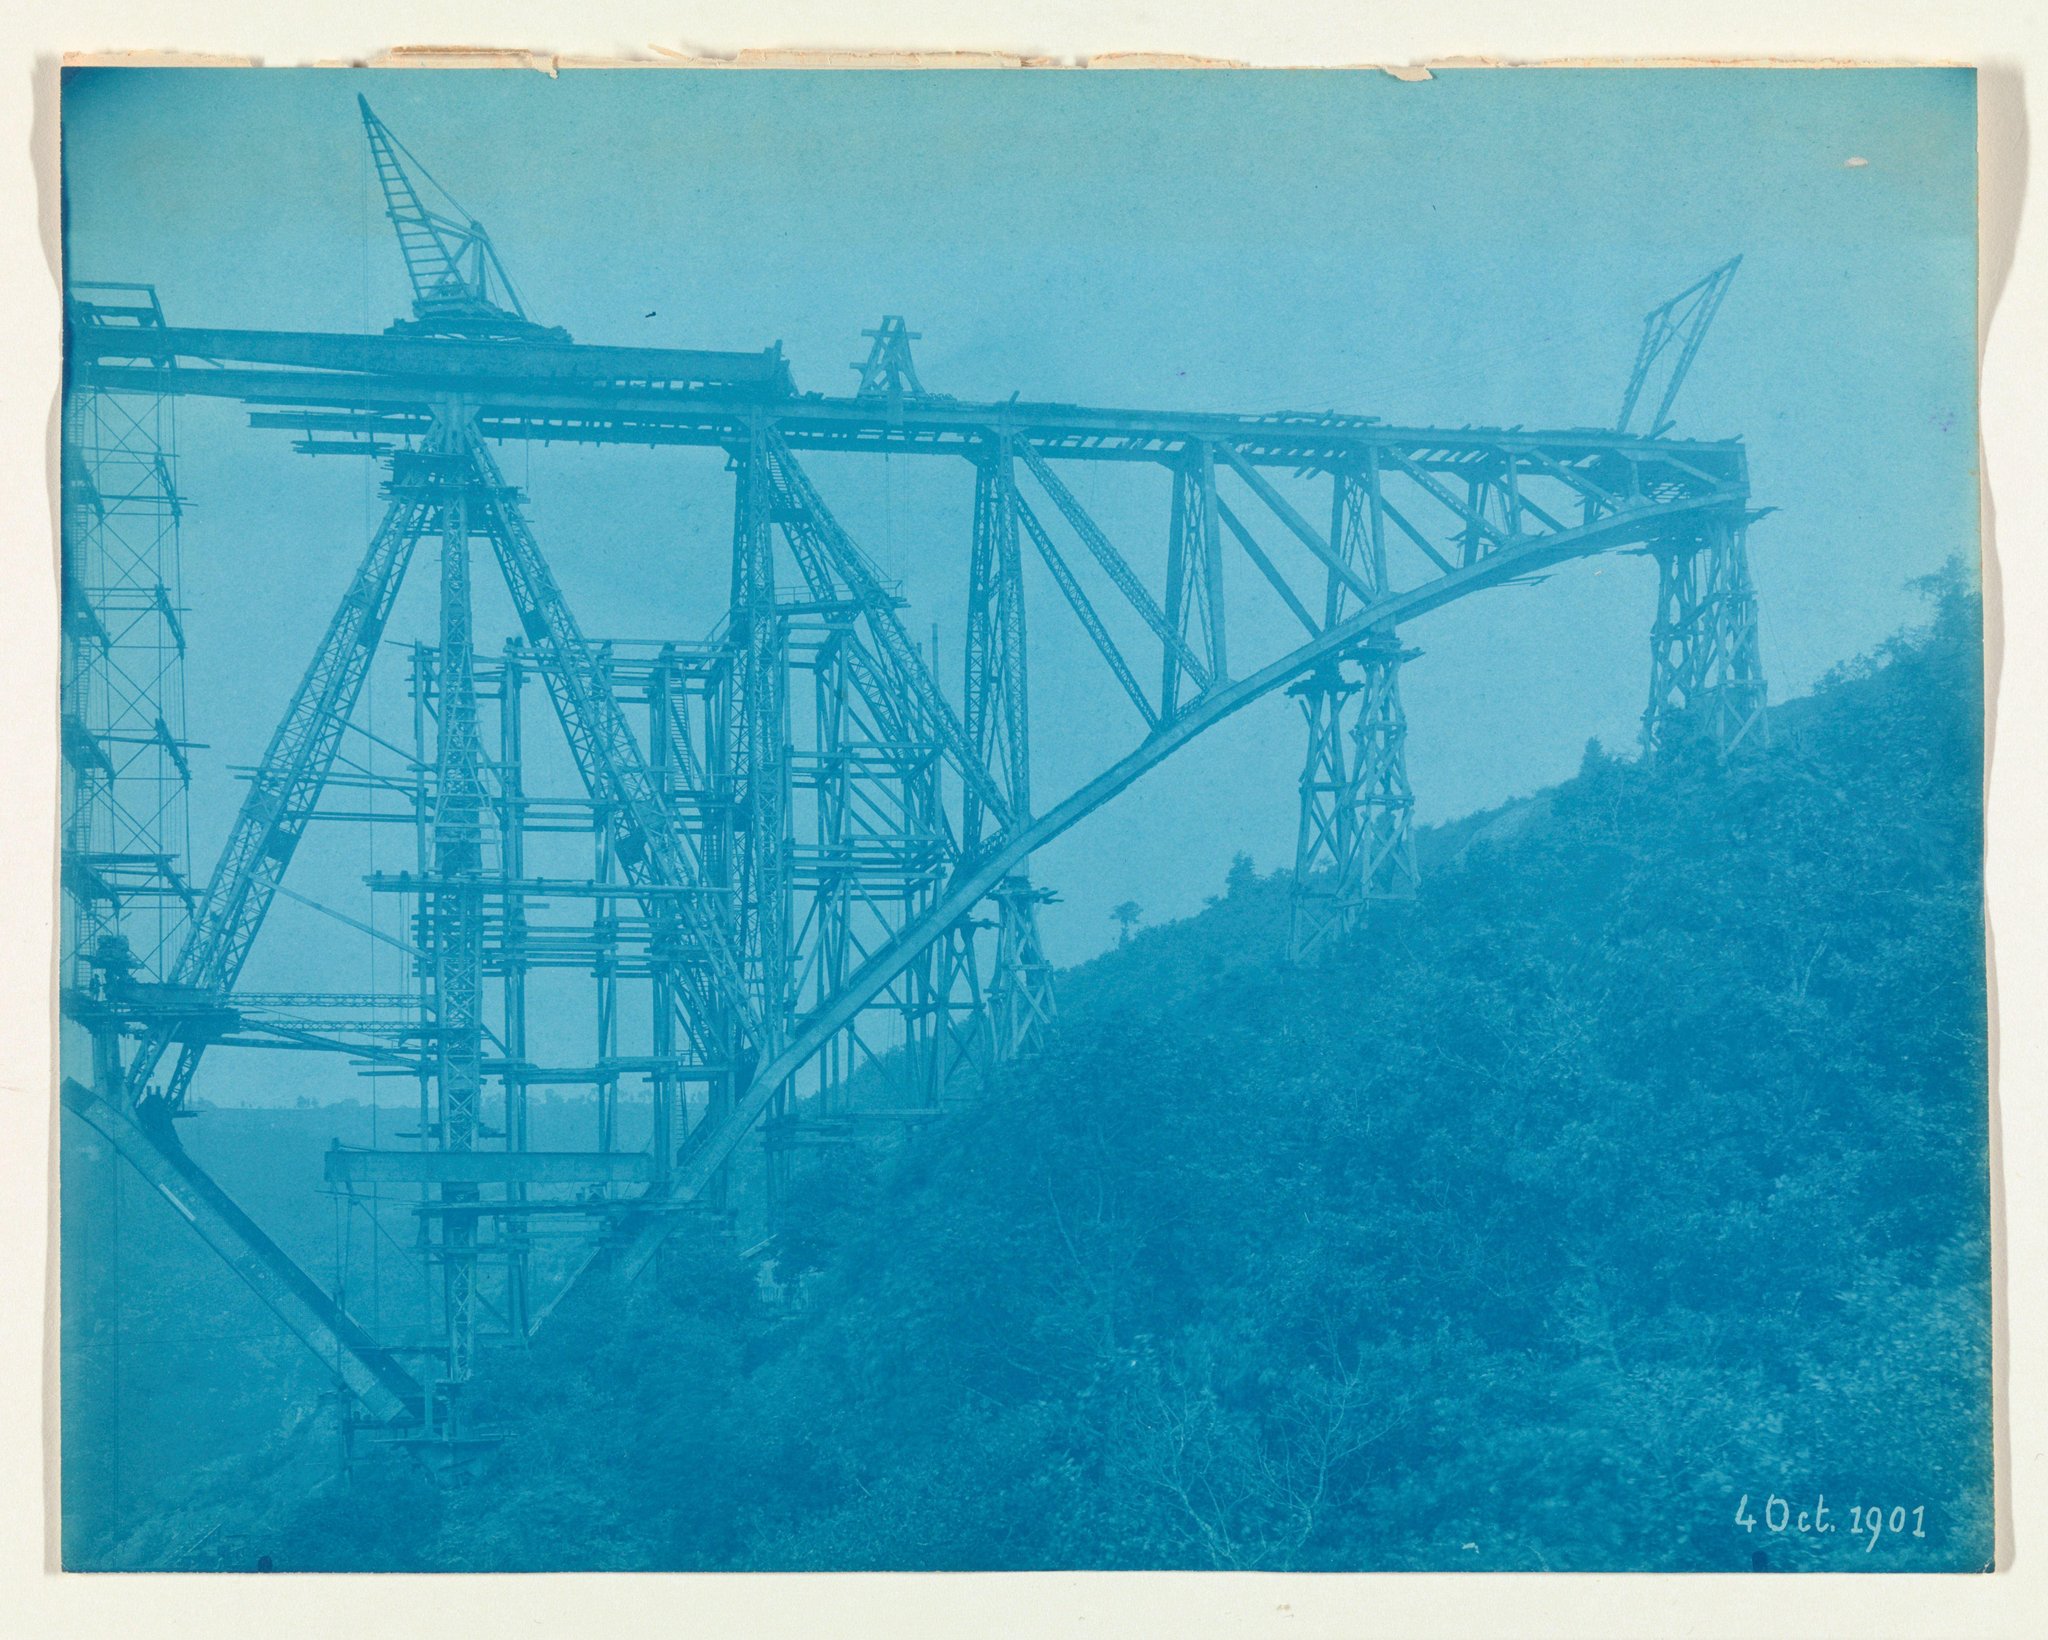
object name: photograph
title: Aanleg van het Viaur Viaduct in Frankrijk door de Societé de Construction des Battignolles, 4 oktober 1901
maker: Anonymous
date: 1901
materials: photographic support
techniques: cyanotype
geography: france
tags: viaduct, making the overground structures (~ building activities)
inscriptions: date